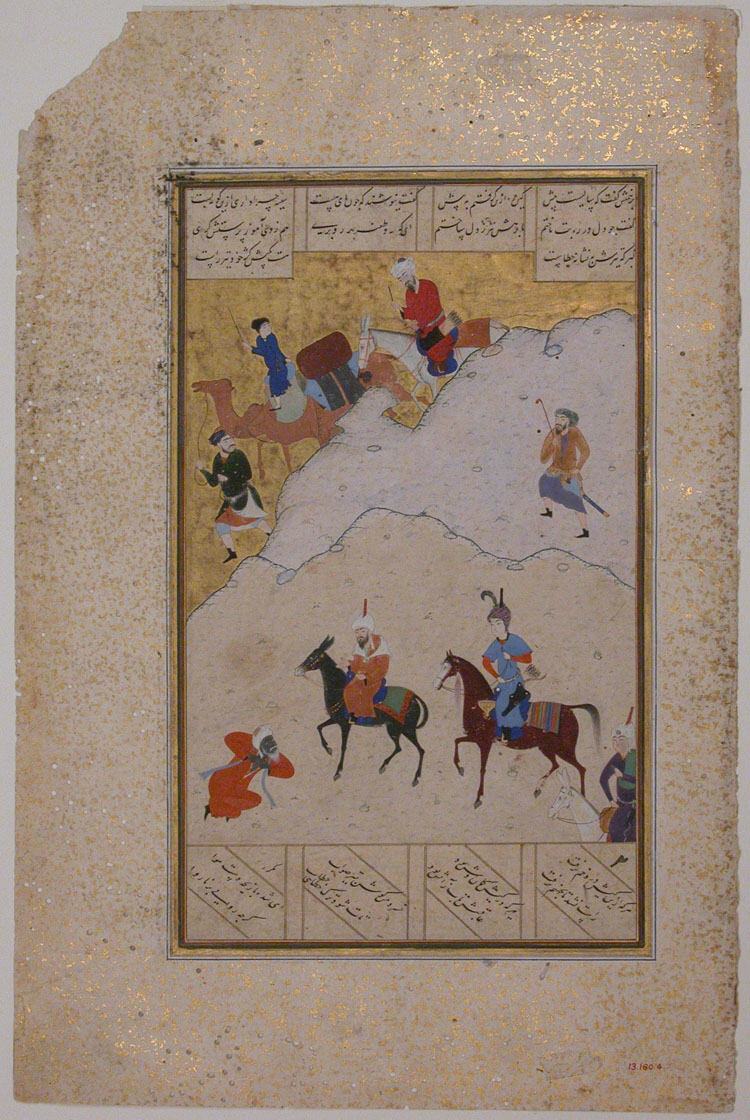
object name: folio from an illustrated manuscript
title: "Muslim Pilgrim to Mecca Meets a Brahman on the Road", Folio from a Khamsa (Quintet) of Amir Khusrau Dihlavi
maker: ala al-din muhammad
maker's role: calligrapher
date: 1520-1525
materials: gold, ink, paper, watercolor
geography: afghanistan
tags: men,camels,horses